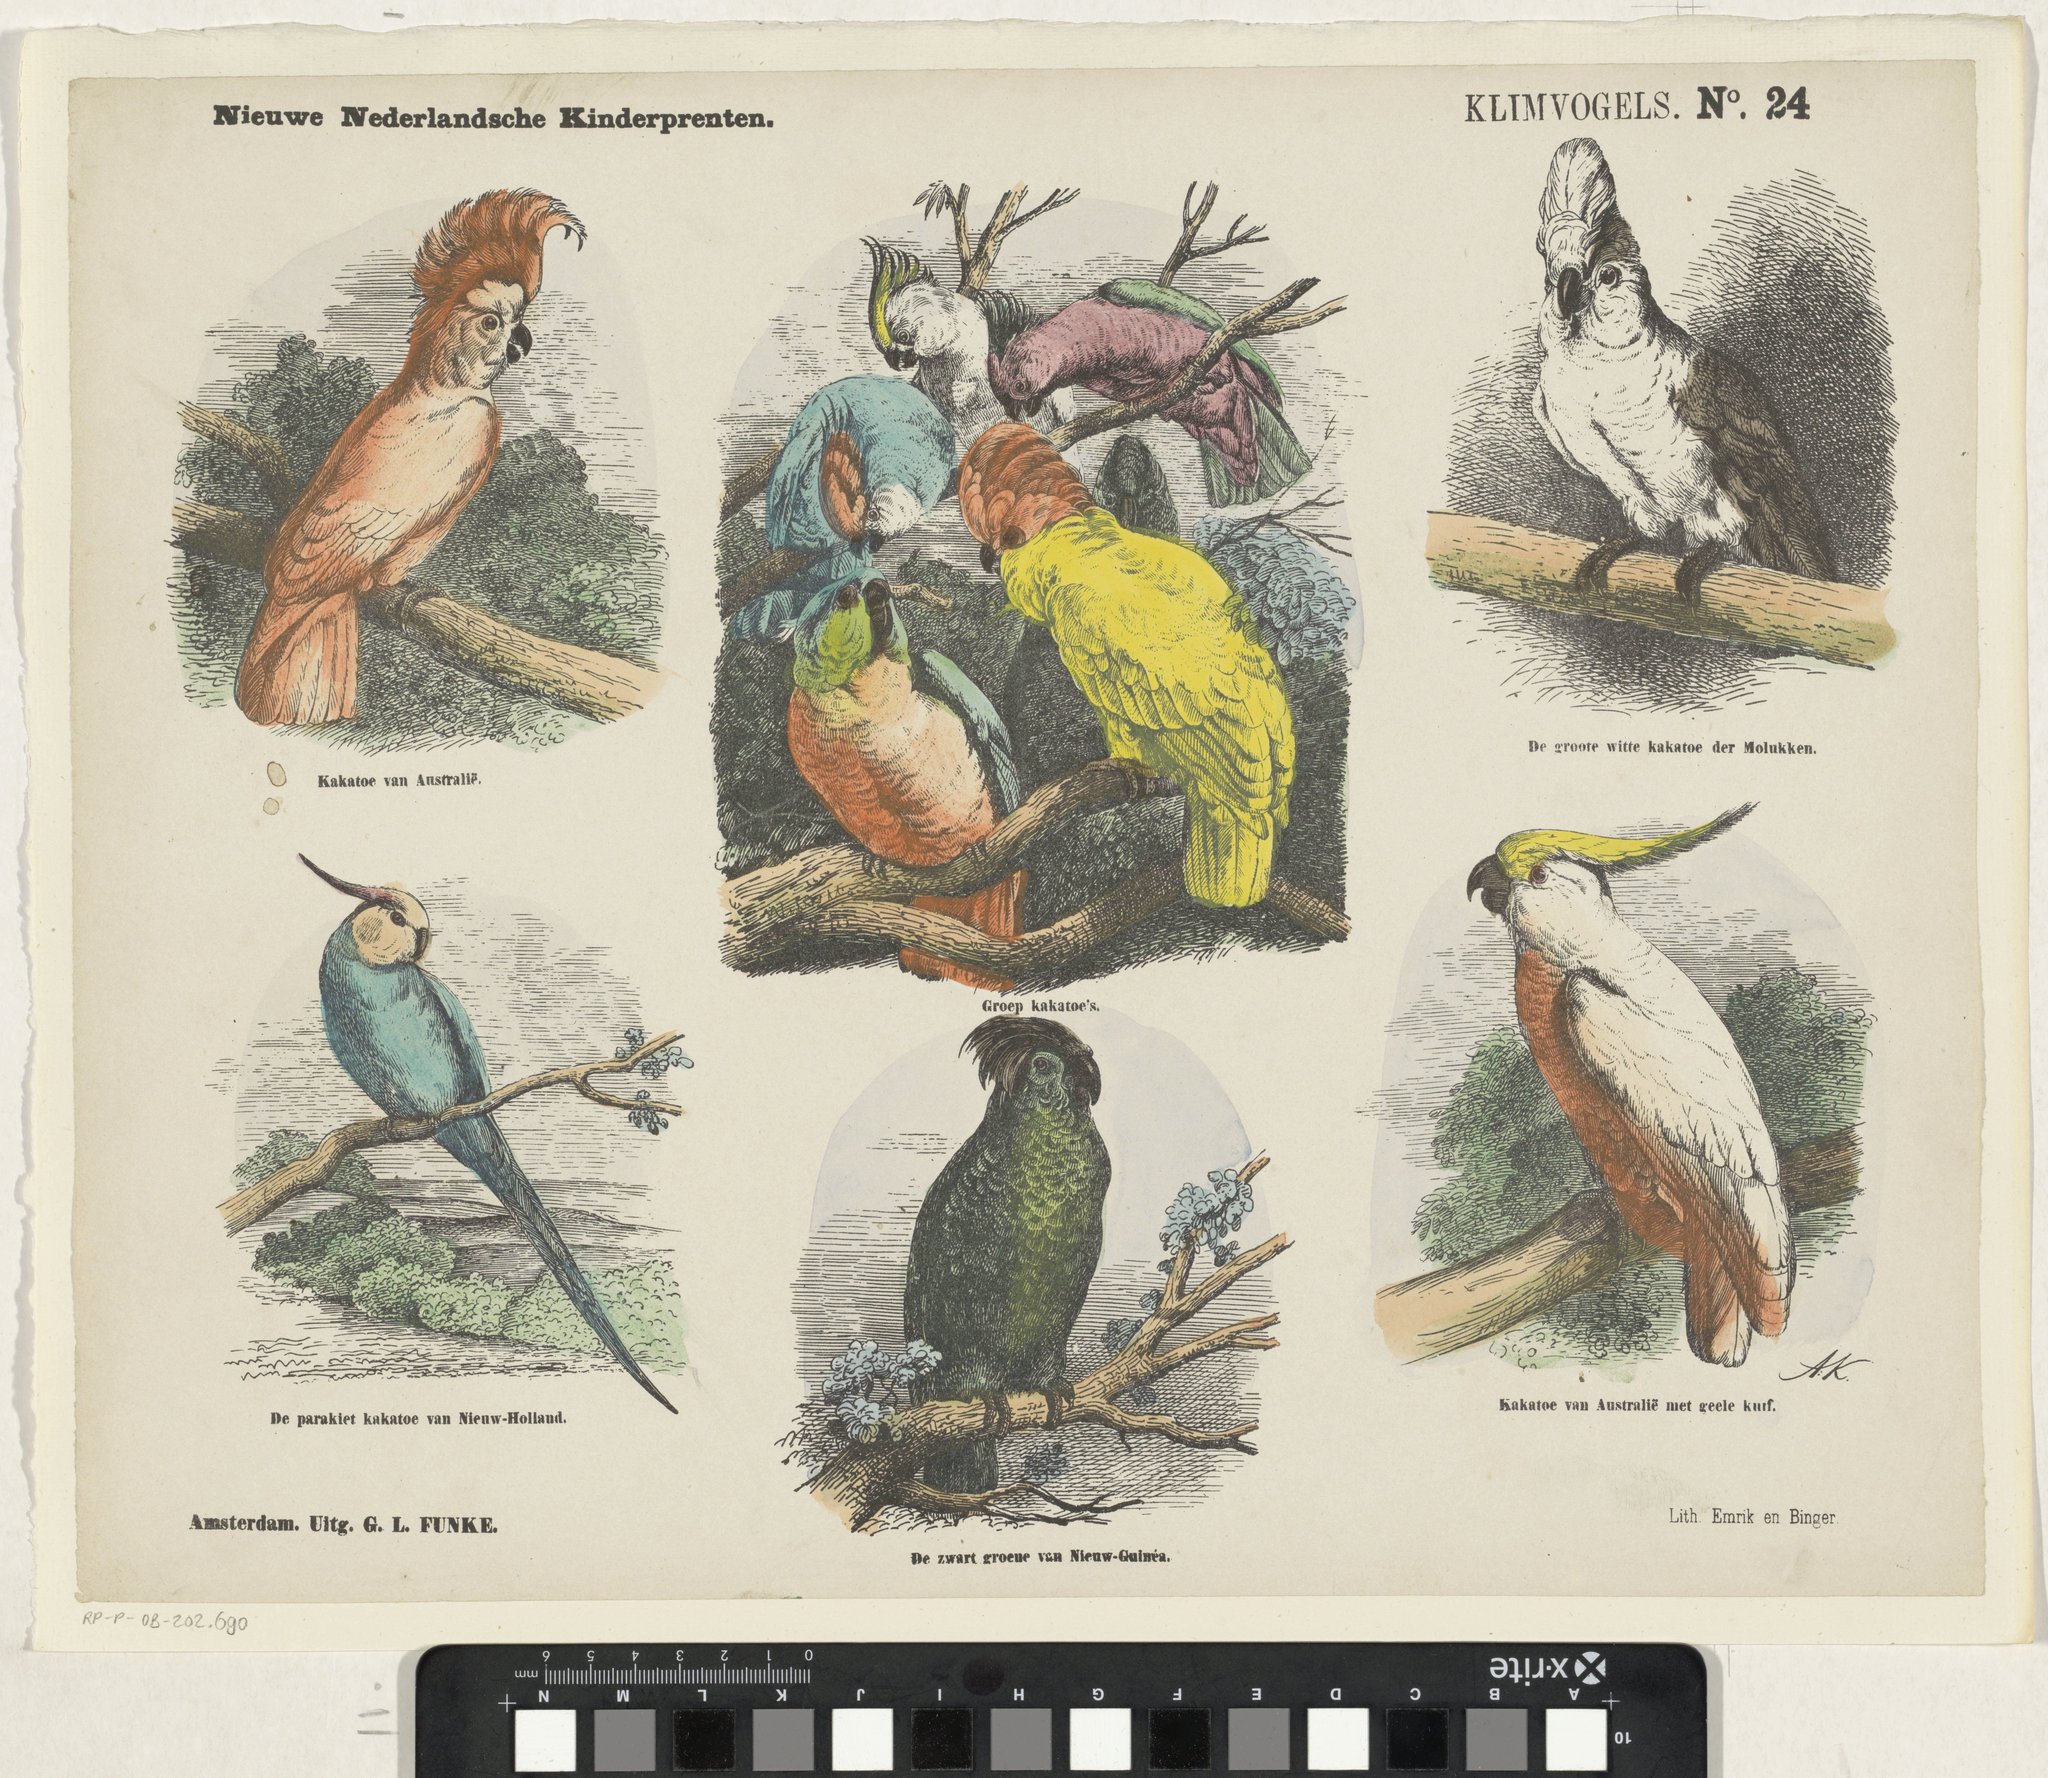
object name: popular print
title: Klimvogels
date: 1865-1875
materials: paper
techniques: colour, letterpress printing, lithograph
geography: haarlem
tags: ornamental birds: cockatoo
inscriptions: collector's mark: Lugt 2760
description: Blad met 6 voorstellingen van kaketoes. Onder elke afbeelding een onderschrift. Genummerd rechtsboven: No. 24.